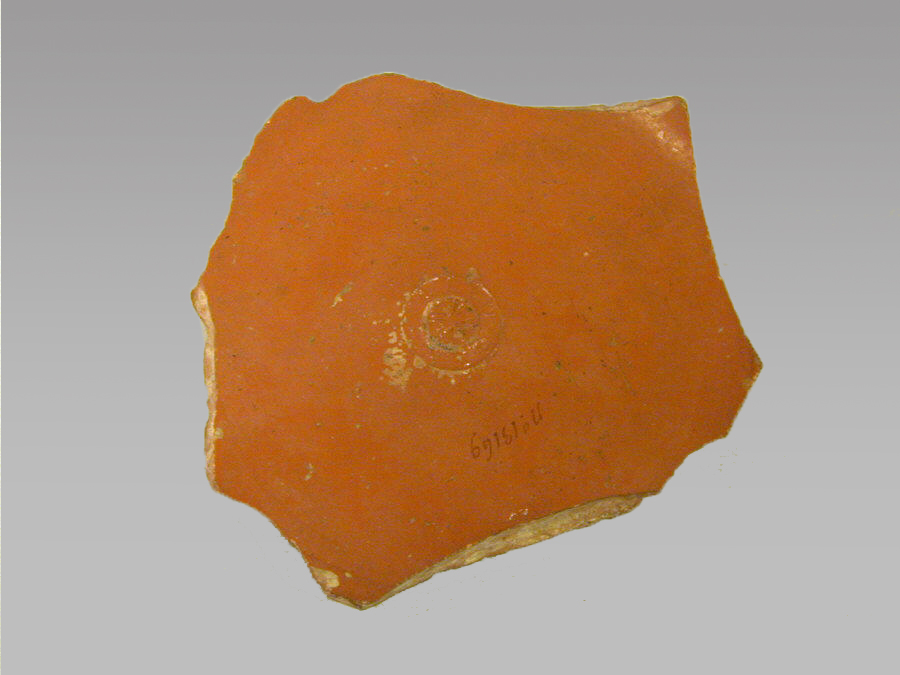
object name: vase fragment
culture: roman, gaul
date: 120 BCE-300 CE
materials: terracotta